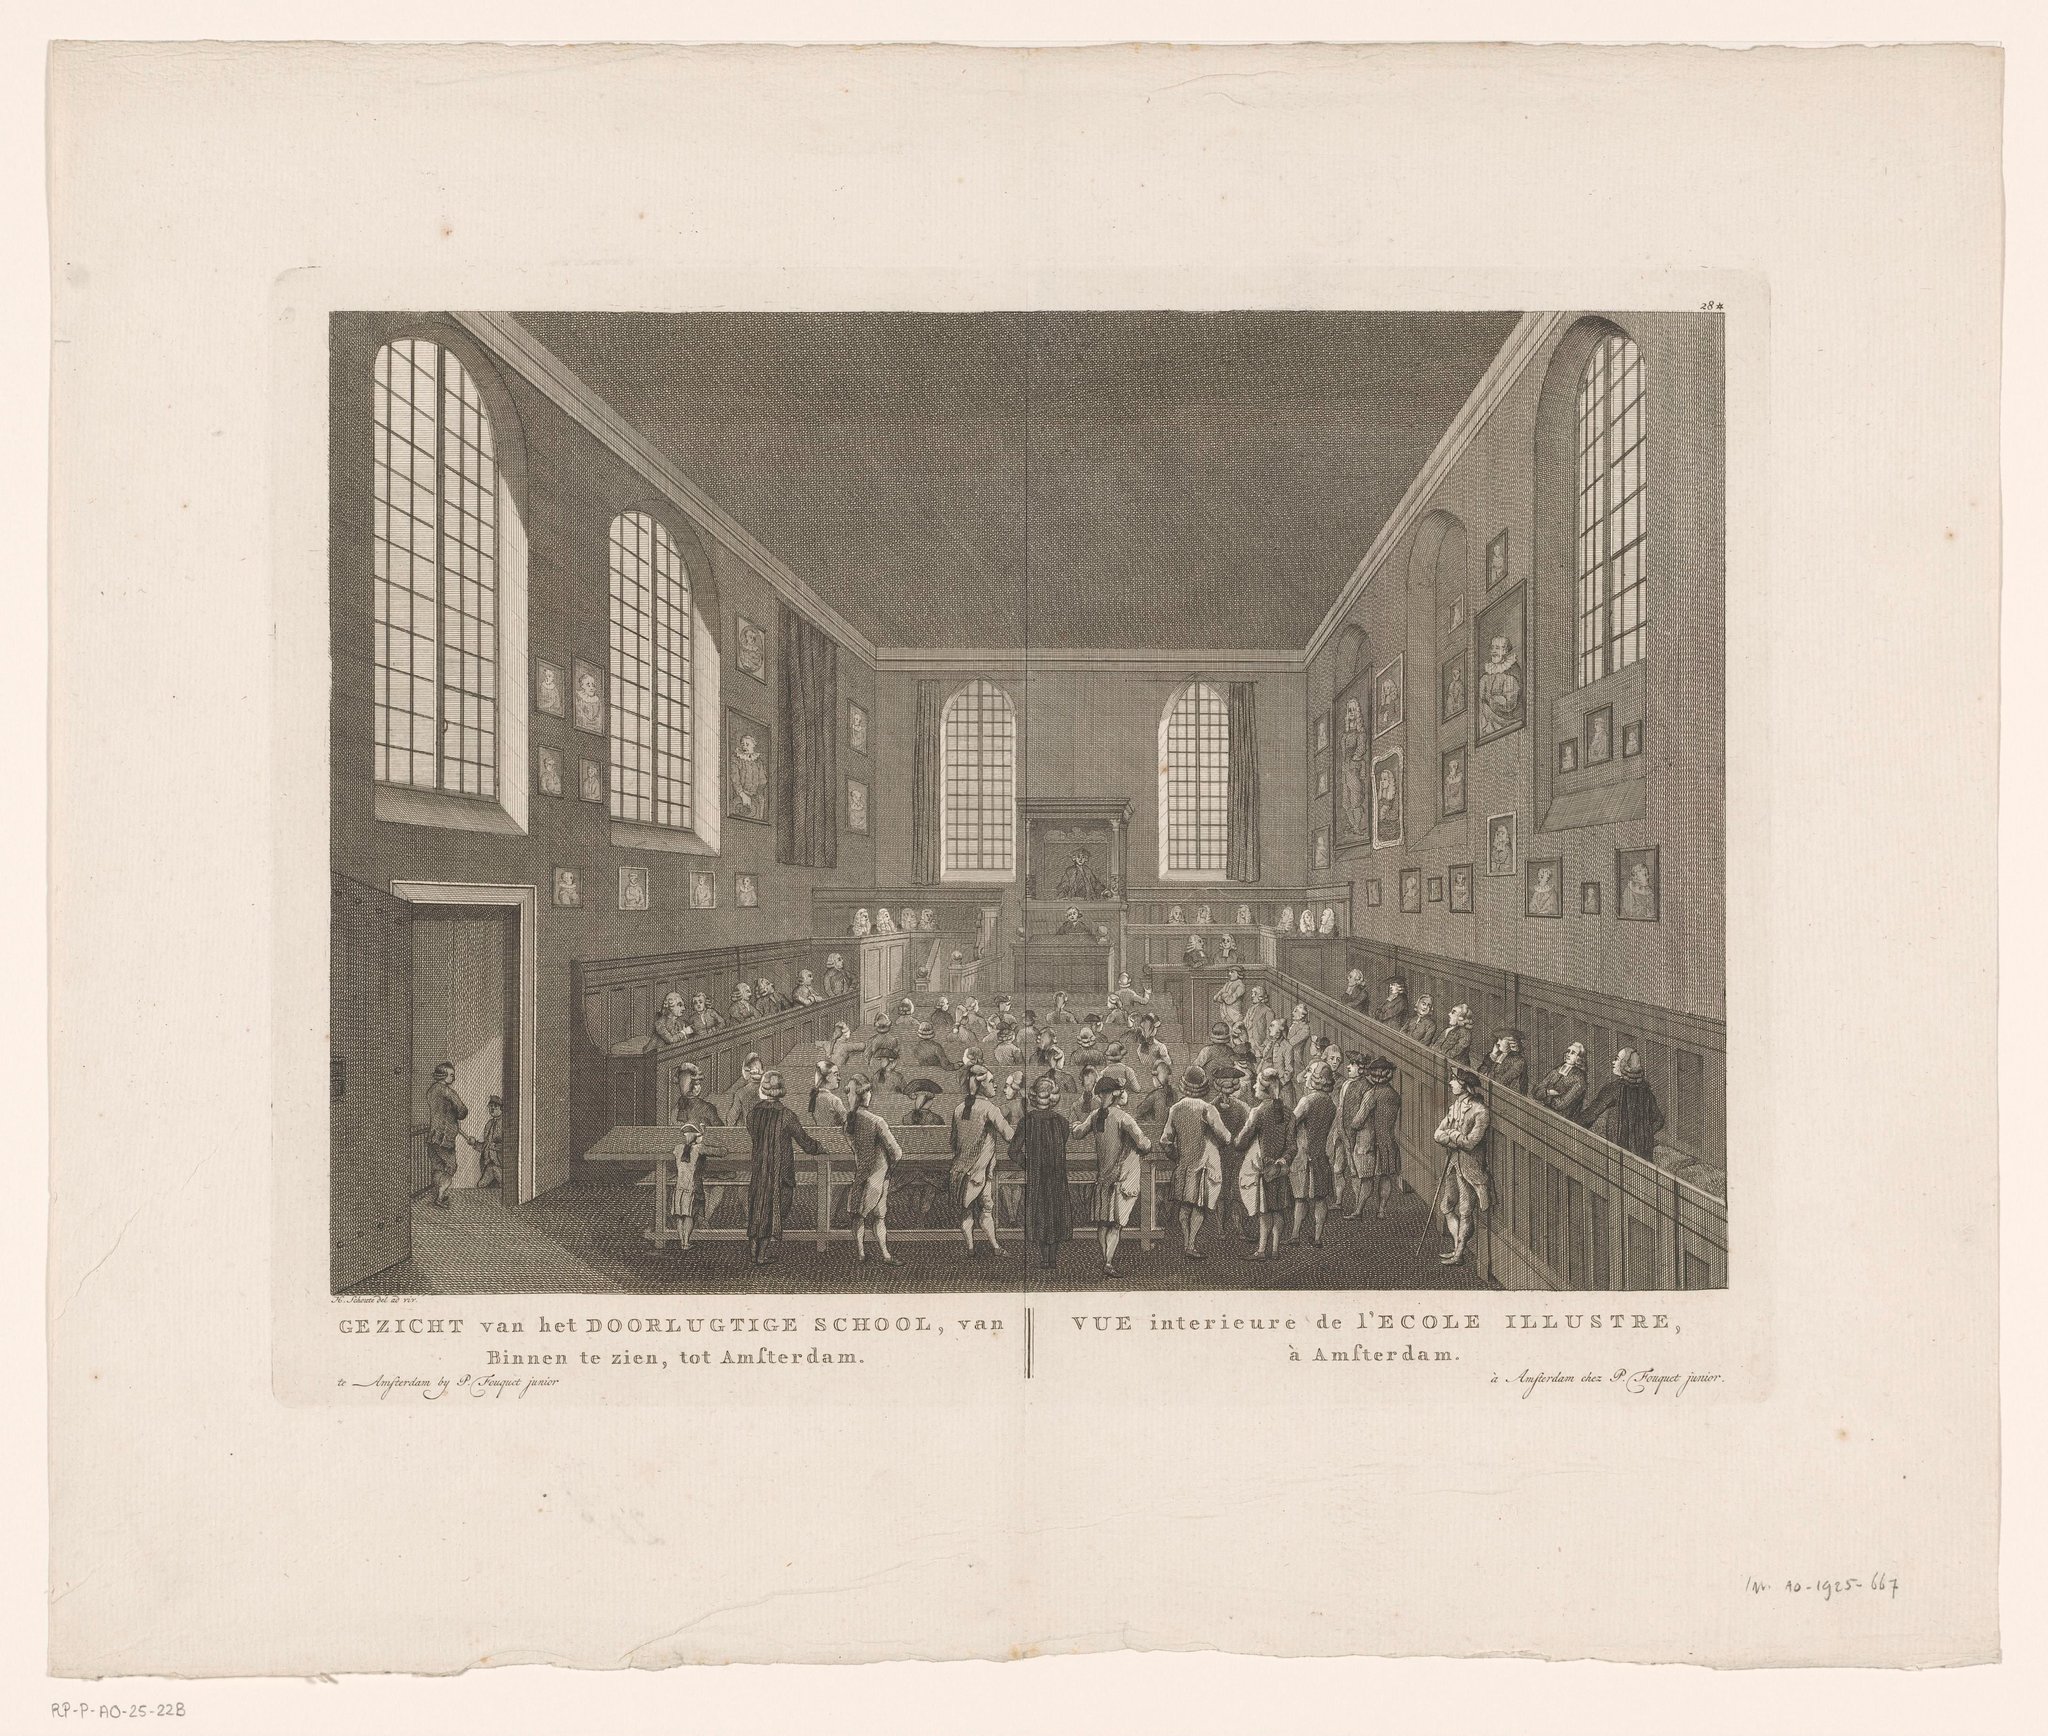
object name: print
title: Interieur van het Athenaeum Illustre te Amsterdam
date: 1770-1783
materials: paper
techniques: engraving, etching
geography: amsterdam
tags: lecture ~ university, university building, college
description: Deze prent is ook gebruikt in de zogenaamde Atlas van Fouquet.* Pierre Fouquet gaf vanaf 1760 stadsgezichten van Amsterdam - naar tekeningen van verschillende kunstenaars, gemaakt door verschillende prentmakers - uit. Deze prenten werden aanvankelijk los of in series verkocht. Zoals toen gebruikelijk kon de koper de prenten zelf laten inbinden. Hiertoe gaf Fouquet tussen 1778 en 1783 een titelblad, plattegrond en inhoudsopgave van de tot dusver 100 uitgegeven prenten uit (1). Gezien de inhoud afhankelijk was van wat de koper had verzameld verschilt de inhoud van de verschillende bewaarde Fouquetatlassen onder deze titel sterk. Ook zijn er exemplaren bekend waar tevens andere prenten aan zijn toegevoegd. Omdat er behoefte bleek aan uitleg bij de platen werd in 1783 een nieuwe versie van de atlas uitgegeven, aangevuld met tekst en twee prenten. De aangegeven volgorde veranderde maar de platen van de al eerder uitgegeven prenten bleven ongewijzigd. Deze uitgave werd in opdracht van Fouquet gedrukt bij Daniël Jean Changuion en Petrus den Hengst (2). Een tiental platen werd bijgewerkt en verscheen, met nieuw impressum, in het vervolg van Wagenaars geschiedenis van Amsterdam, uitgeven door Petrus Conradi en Folkert van der Plaats (3). Een aantal jaar na het overlijden van Fouquet kwam Evert Maaskamp met een nieuwe uitgave van de atlas, met verbeterde tekst en toevoeging van twee prenten. Op alle platen verwijderde hij het oude en liet hij zijn eigen impressum zetten (4). De huidige staat van de prent komt voor in exemplaren van de onder (1) en (2) genoemde werken. * Onder de Atlas van Fouquet of Fouquetatlas verstaan we de hieronder vermelde publicaties (1), (2) en (4). (1). Afbeeldingen van de wyd-vermaarde koopstad Amsterdam benevens des zelvs voornaamste gebouwen en gezigten alle naar het leeven getekend / Receuil des edifices les plus considerables et des plus belles vues, de la fameuse ville d'Amsterdam, dessinées d'après nature. Amsterdam: Pierre Fouquet, 1778-1783. (2). Nieuwe atlas, van de voornaamste gebouwen en gezigten der stad Amsterdam, met derzelver beknopte beschryvingen. 2 delen. Amsterdam: Daniël Jean Changuion en Petrus den Hengst [in opdracht van Pierre Fouquet], 1783. (3). Stijl, Simon. Amsterdam, in zyne geschiedenissen, voorregten, koophandel, gebouwen, kerkenstaat, schoolen, schutterye, gilden en regeeringe, beschreeven. Om te dienen ten vervolge op het werk van Jan Wagenaar (…). 10 delen. Amsterdam en Harlingen: Petrus Conradi en Folkert van der Plaats, 1788-1801. (4). Nieuwe atlas, van de voornaamste gebouwen en gezigten der stad Amsterdam. Met derzelver beknopte beschryvingen. Amsterdam: Evert Maaskamp, 1805. * Het aantal vermelde staten is gebaseerd op het aantal gevonden staten. Mogelijk zijn er meer staten van deze prent.